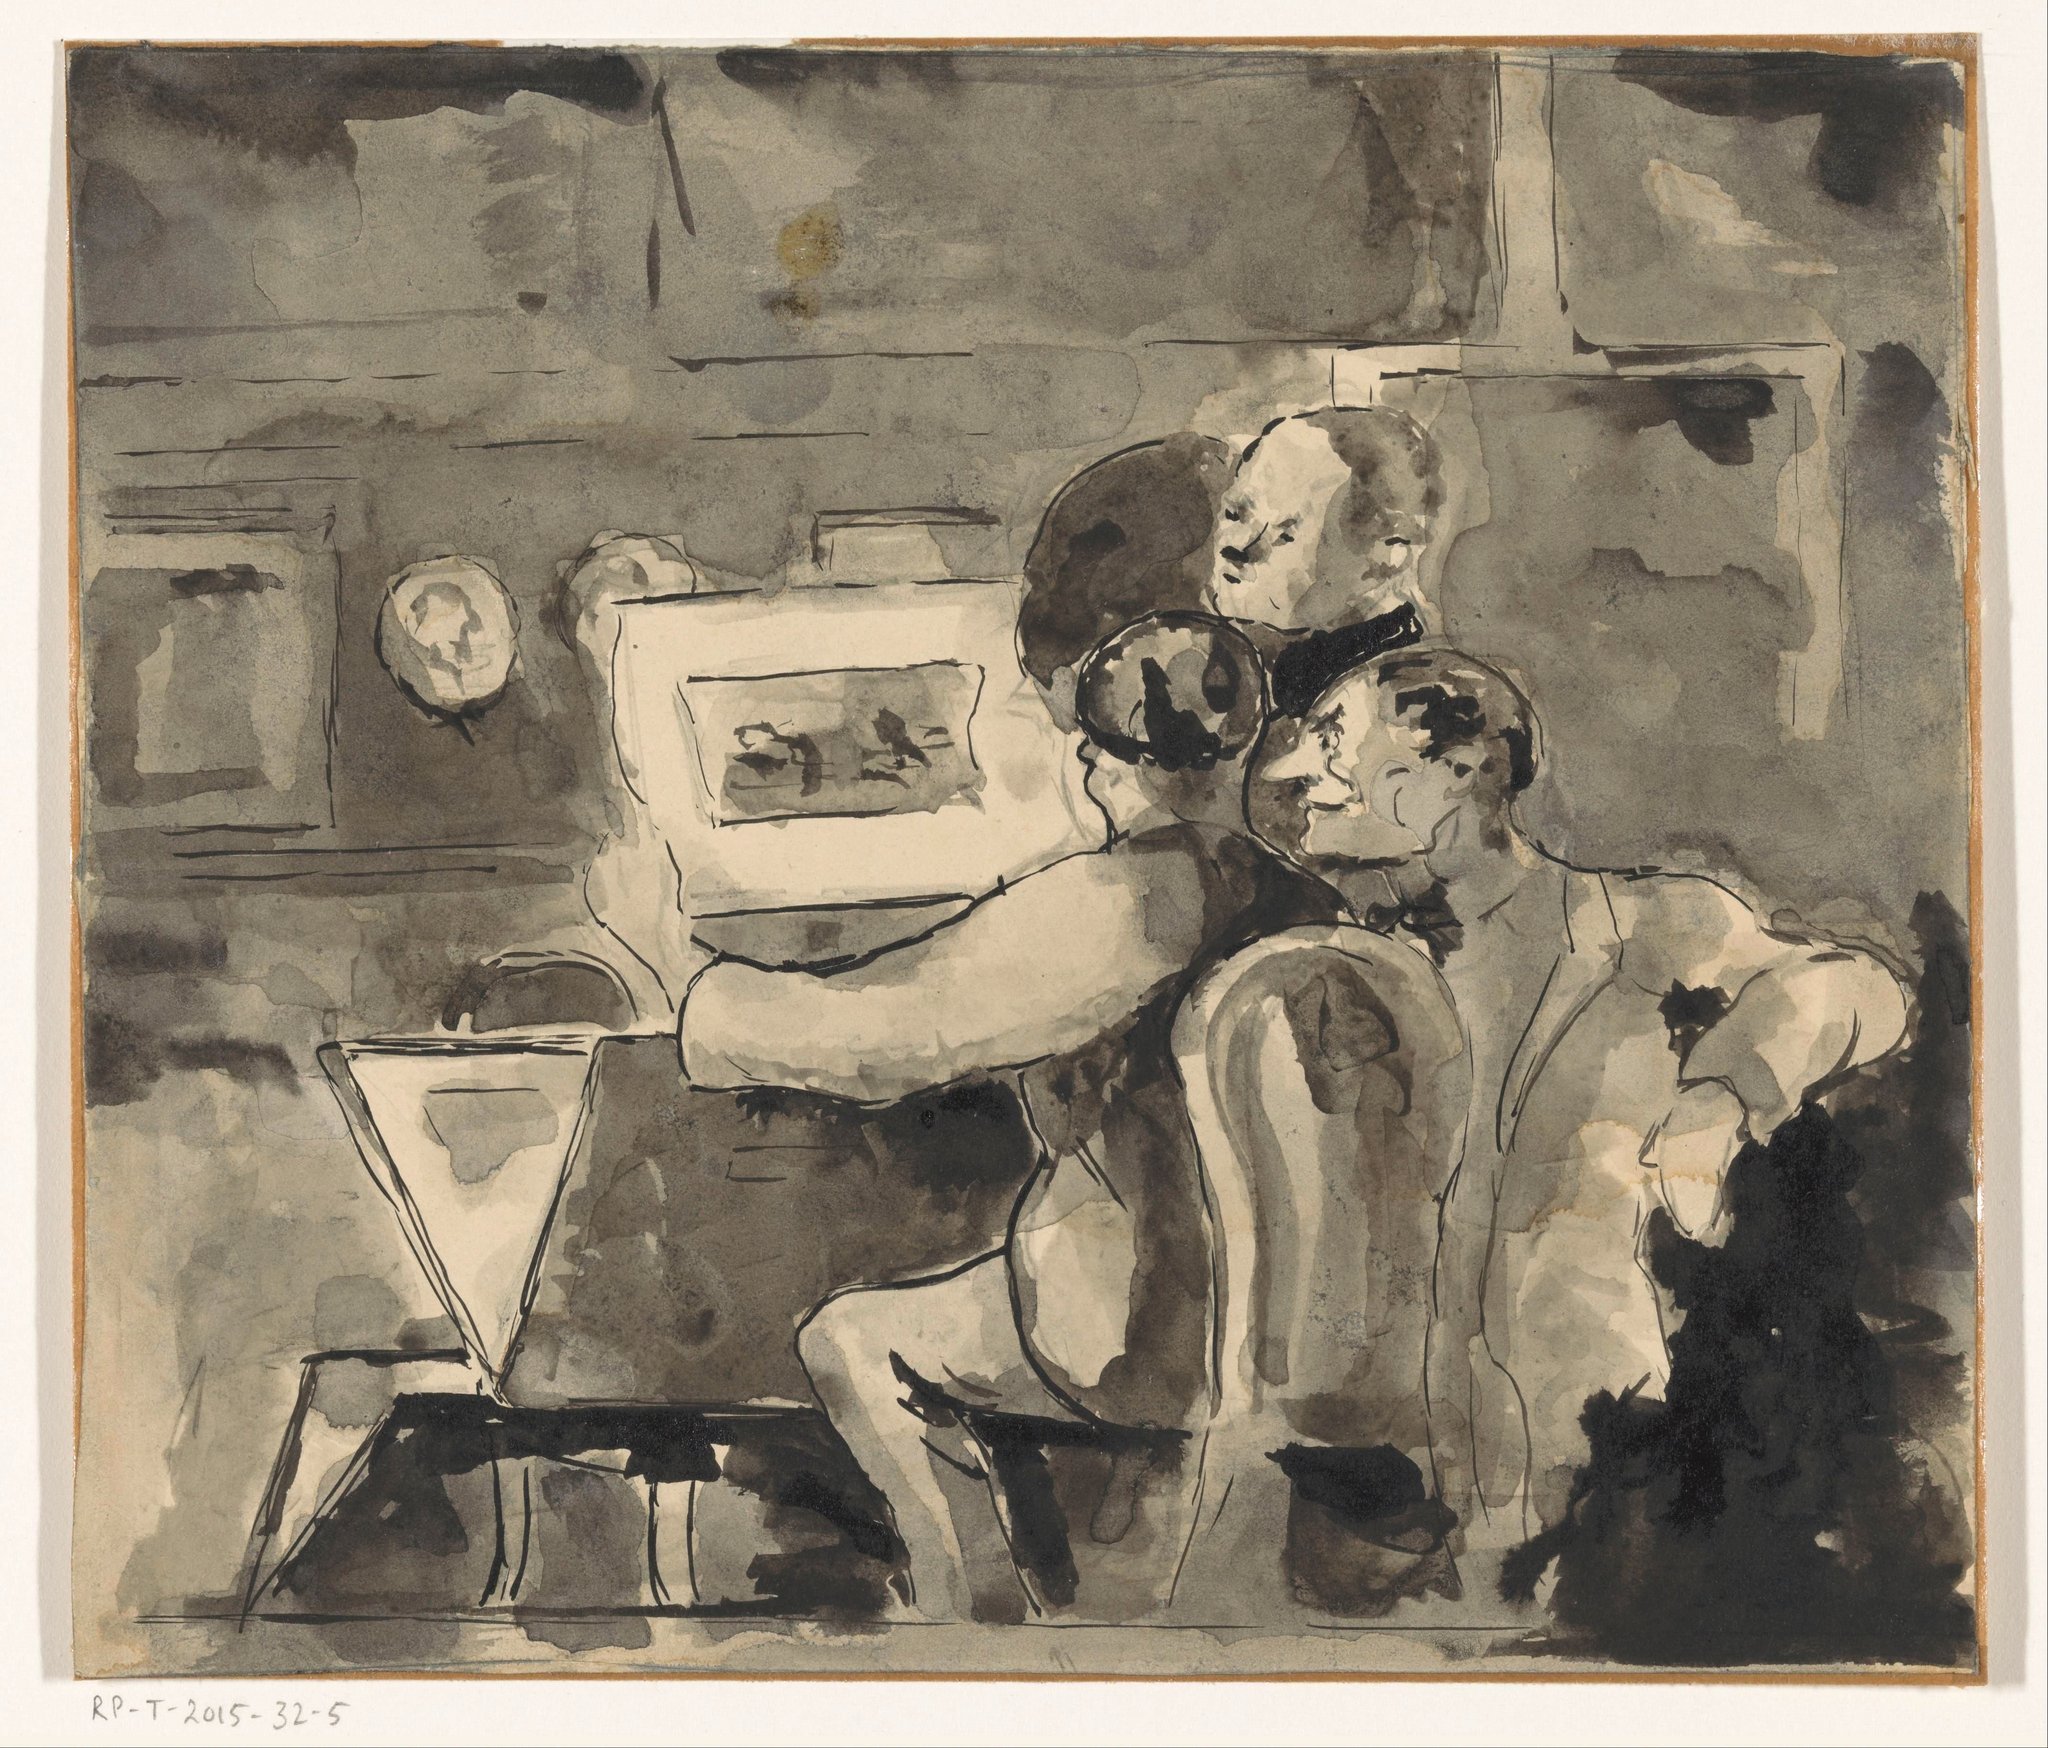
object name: drawing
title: Interior with Three Men Looking at a Print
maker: Anonymous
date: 1900-1950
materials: ink, paper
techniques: brush, pen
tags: art collecting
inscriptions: collector's mark: Lugt 2228, collector's mark: Lugt 4779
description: Three men are engrossed in a work on paper. For this ink wash drawing the anonymous draughtsman loosely copied a drawing by the French caricaturist Jean-Honoré Daumier. The artist meticulously imitated Daumier’s sinuous drawing style, managing to convey movement and expression. Intentionally left unfinished, the drawing invites the viewer into a dynamic world in keeping with the caricature tradition.